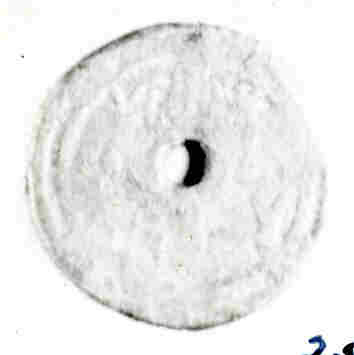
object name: coin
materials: copper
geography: iran